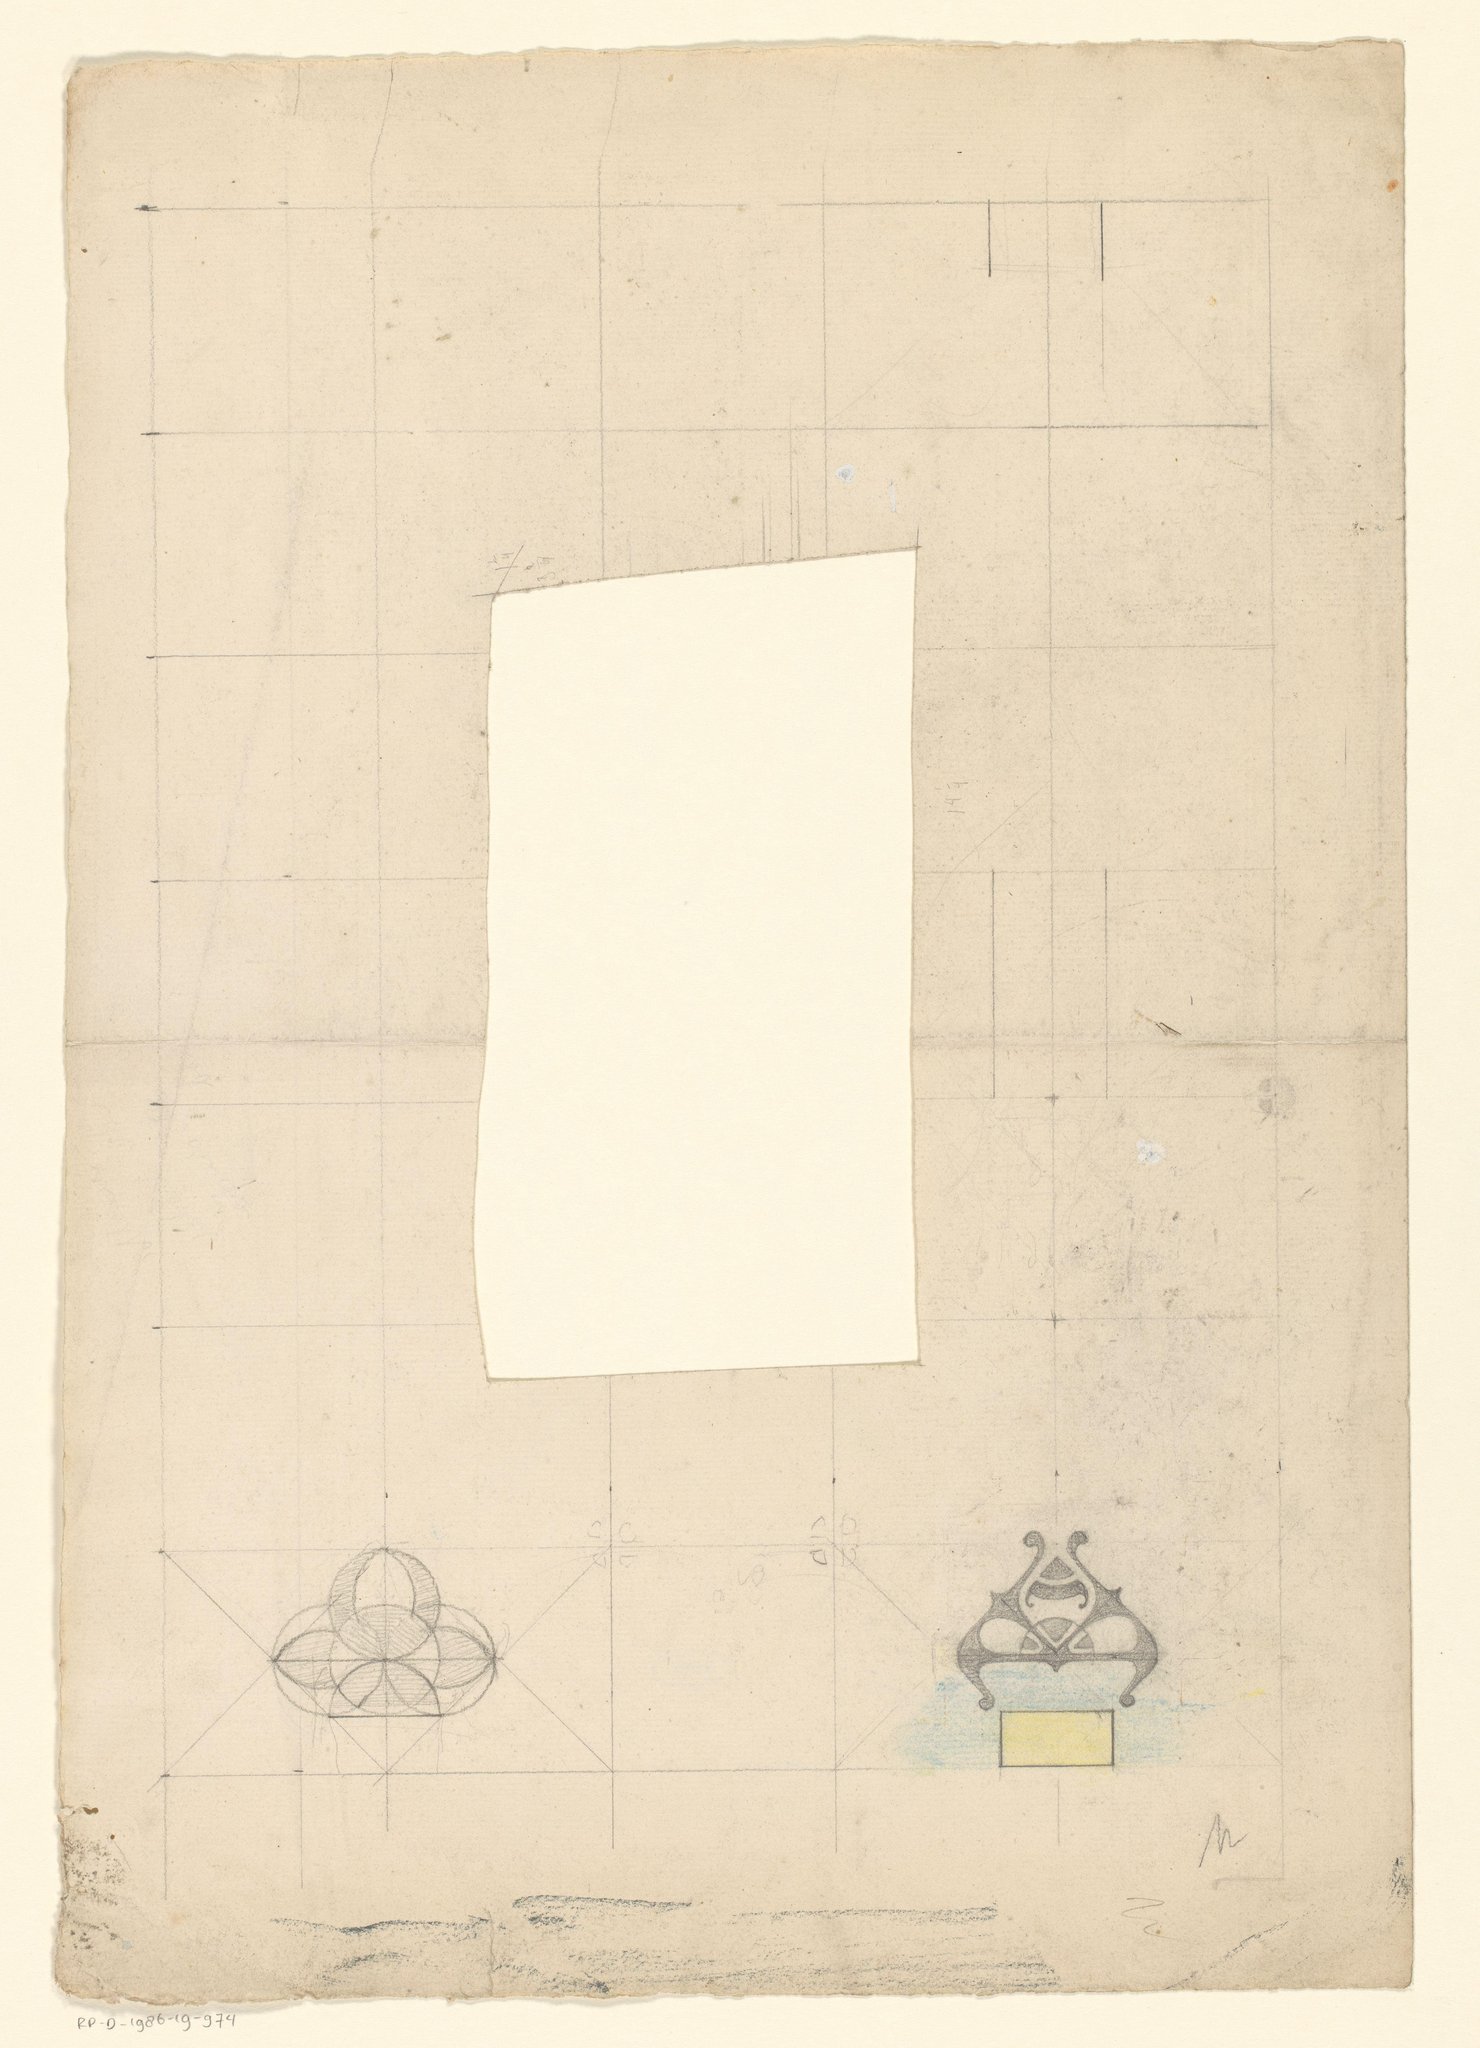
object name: drawing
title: Rechthoekig kader met vlakverdeling en twee ornamenten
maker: reinier willem petrus de vries (1874-1953)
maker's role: draughtsman, print maker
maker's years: 1874-1953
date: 1884-1952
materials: paper, pencil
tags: flowers ~ ornament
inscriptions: collector's mark: ‘R:MVS.’